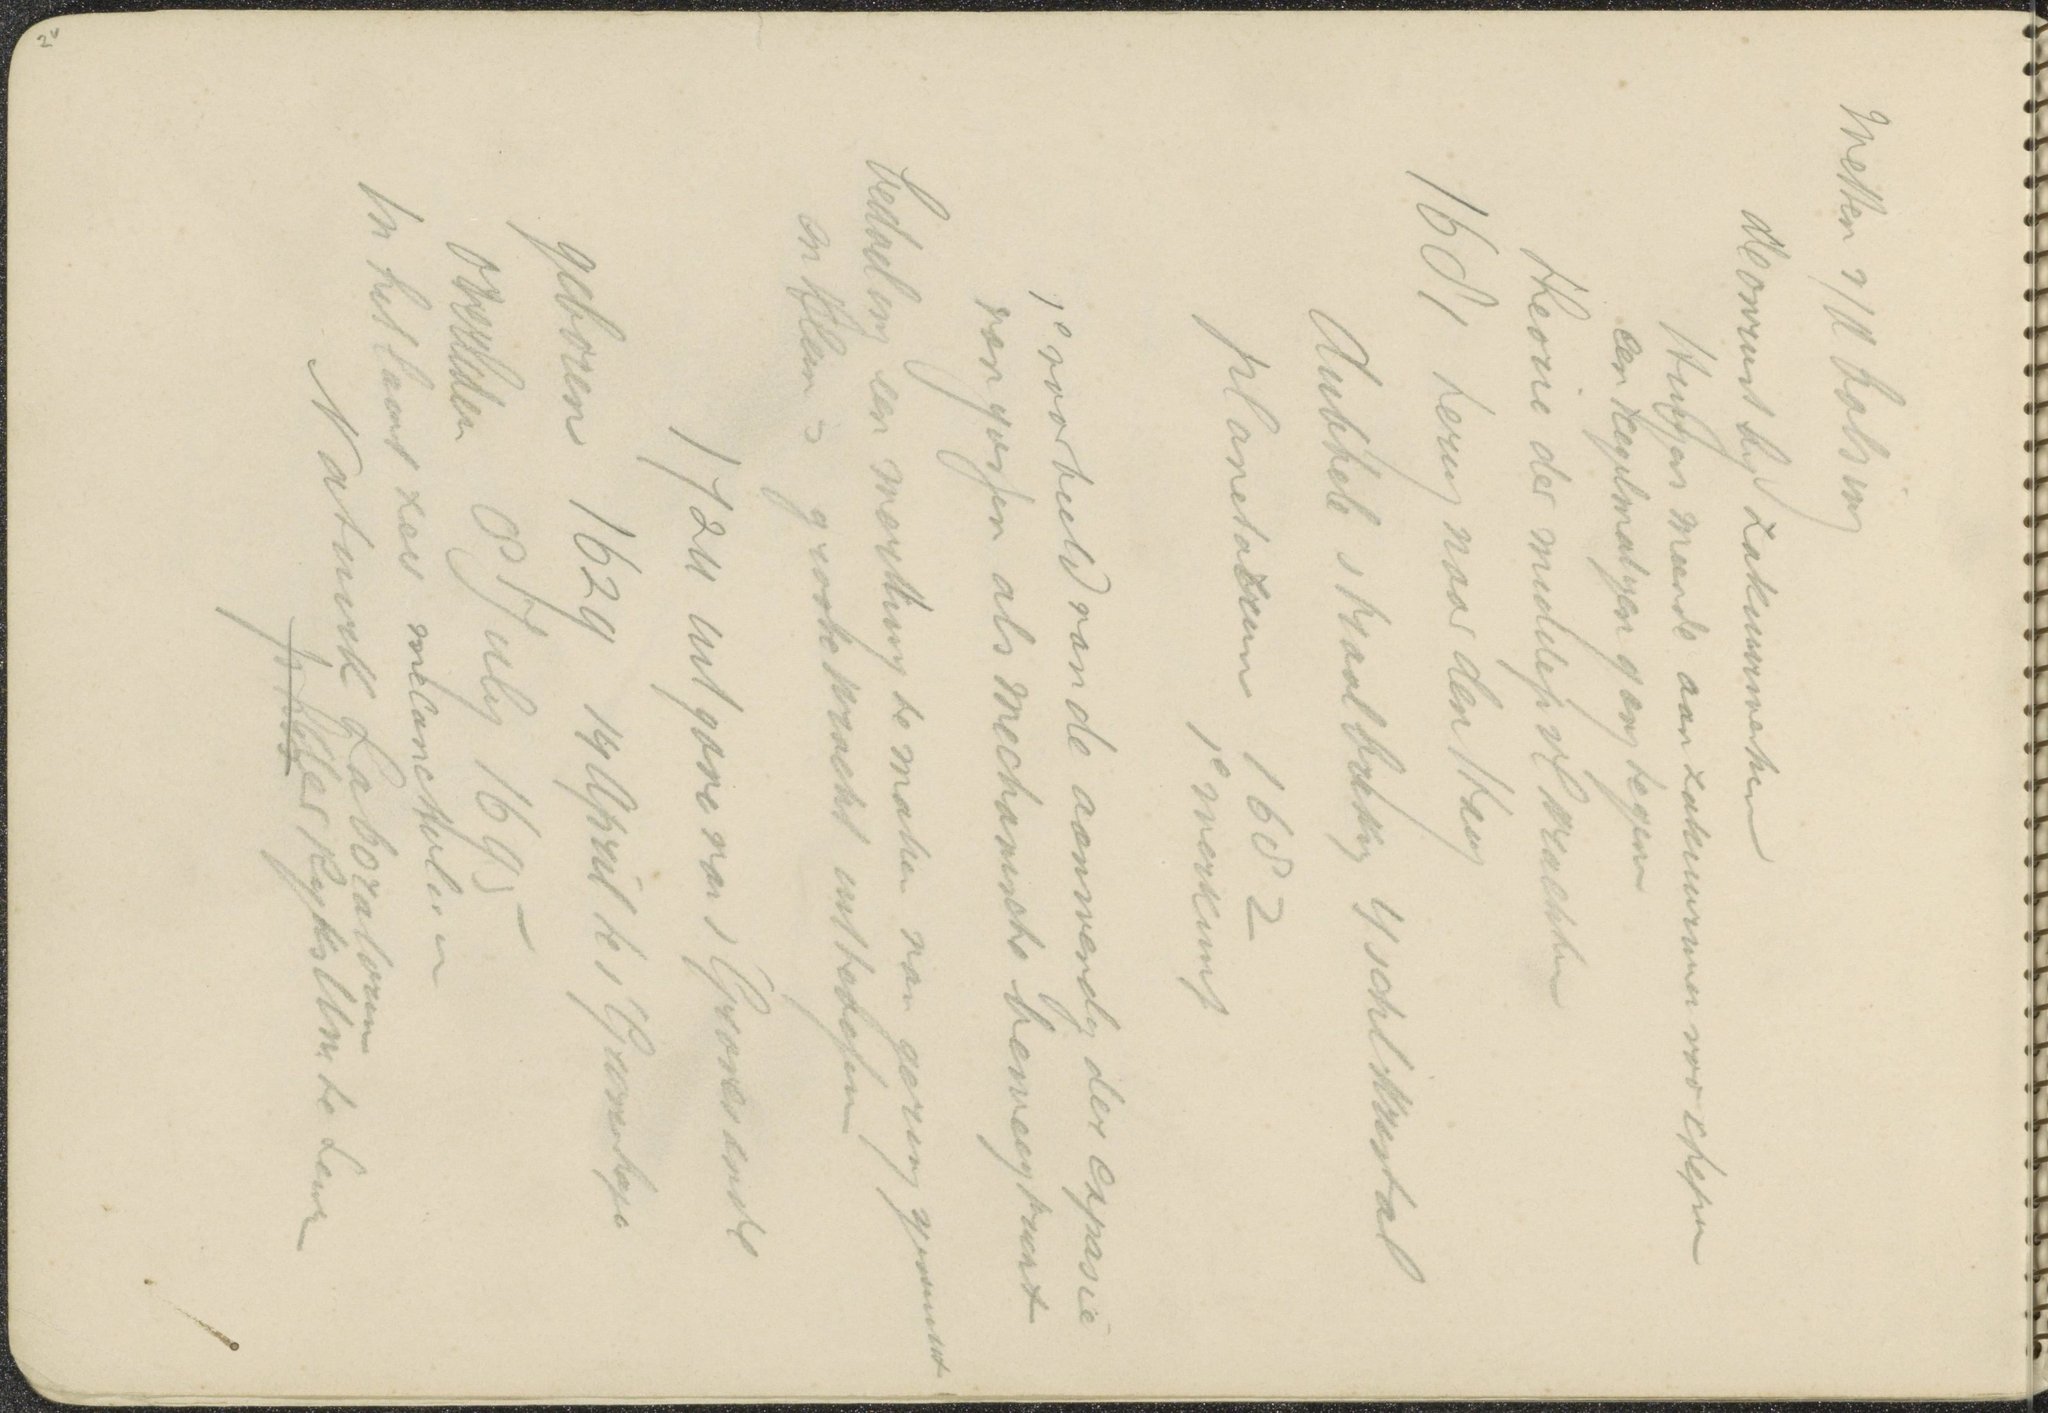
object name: sketchbook leaf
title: Biografische aantekeningen over Christiaan Huygens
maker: carel adolph lion cachet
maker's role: draughtsman, print maker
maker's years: 1864-1945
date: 1934-1943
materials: paper, pencil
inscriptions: annotation: ‘[...]’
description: Blad 2 verso uit een schetsboek met 19 bladen.